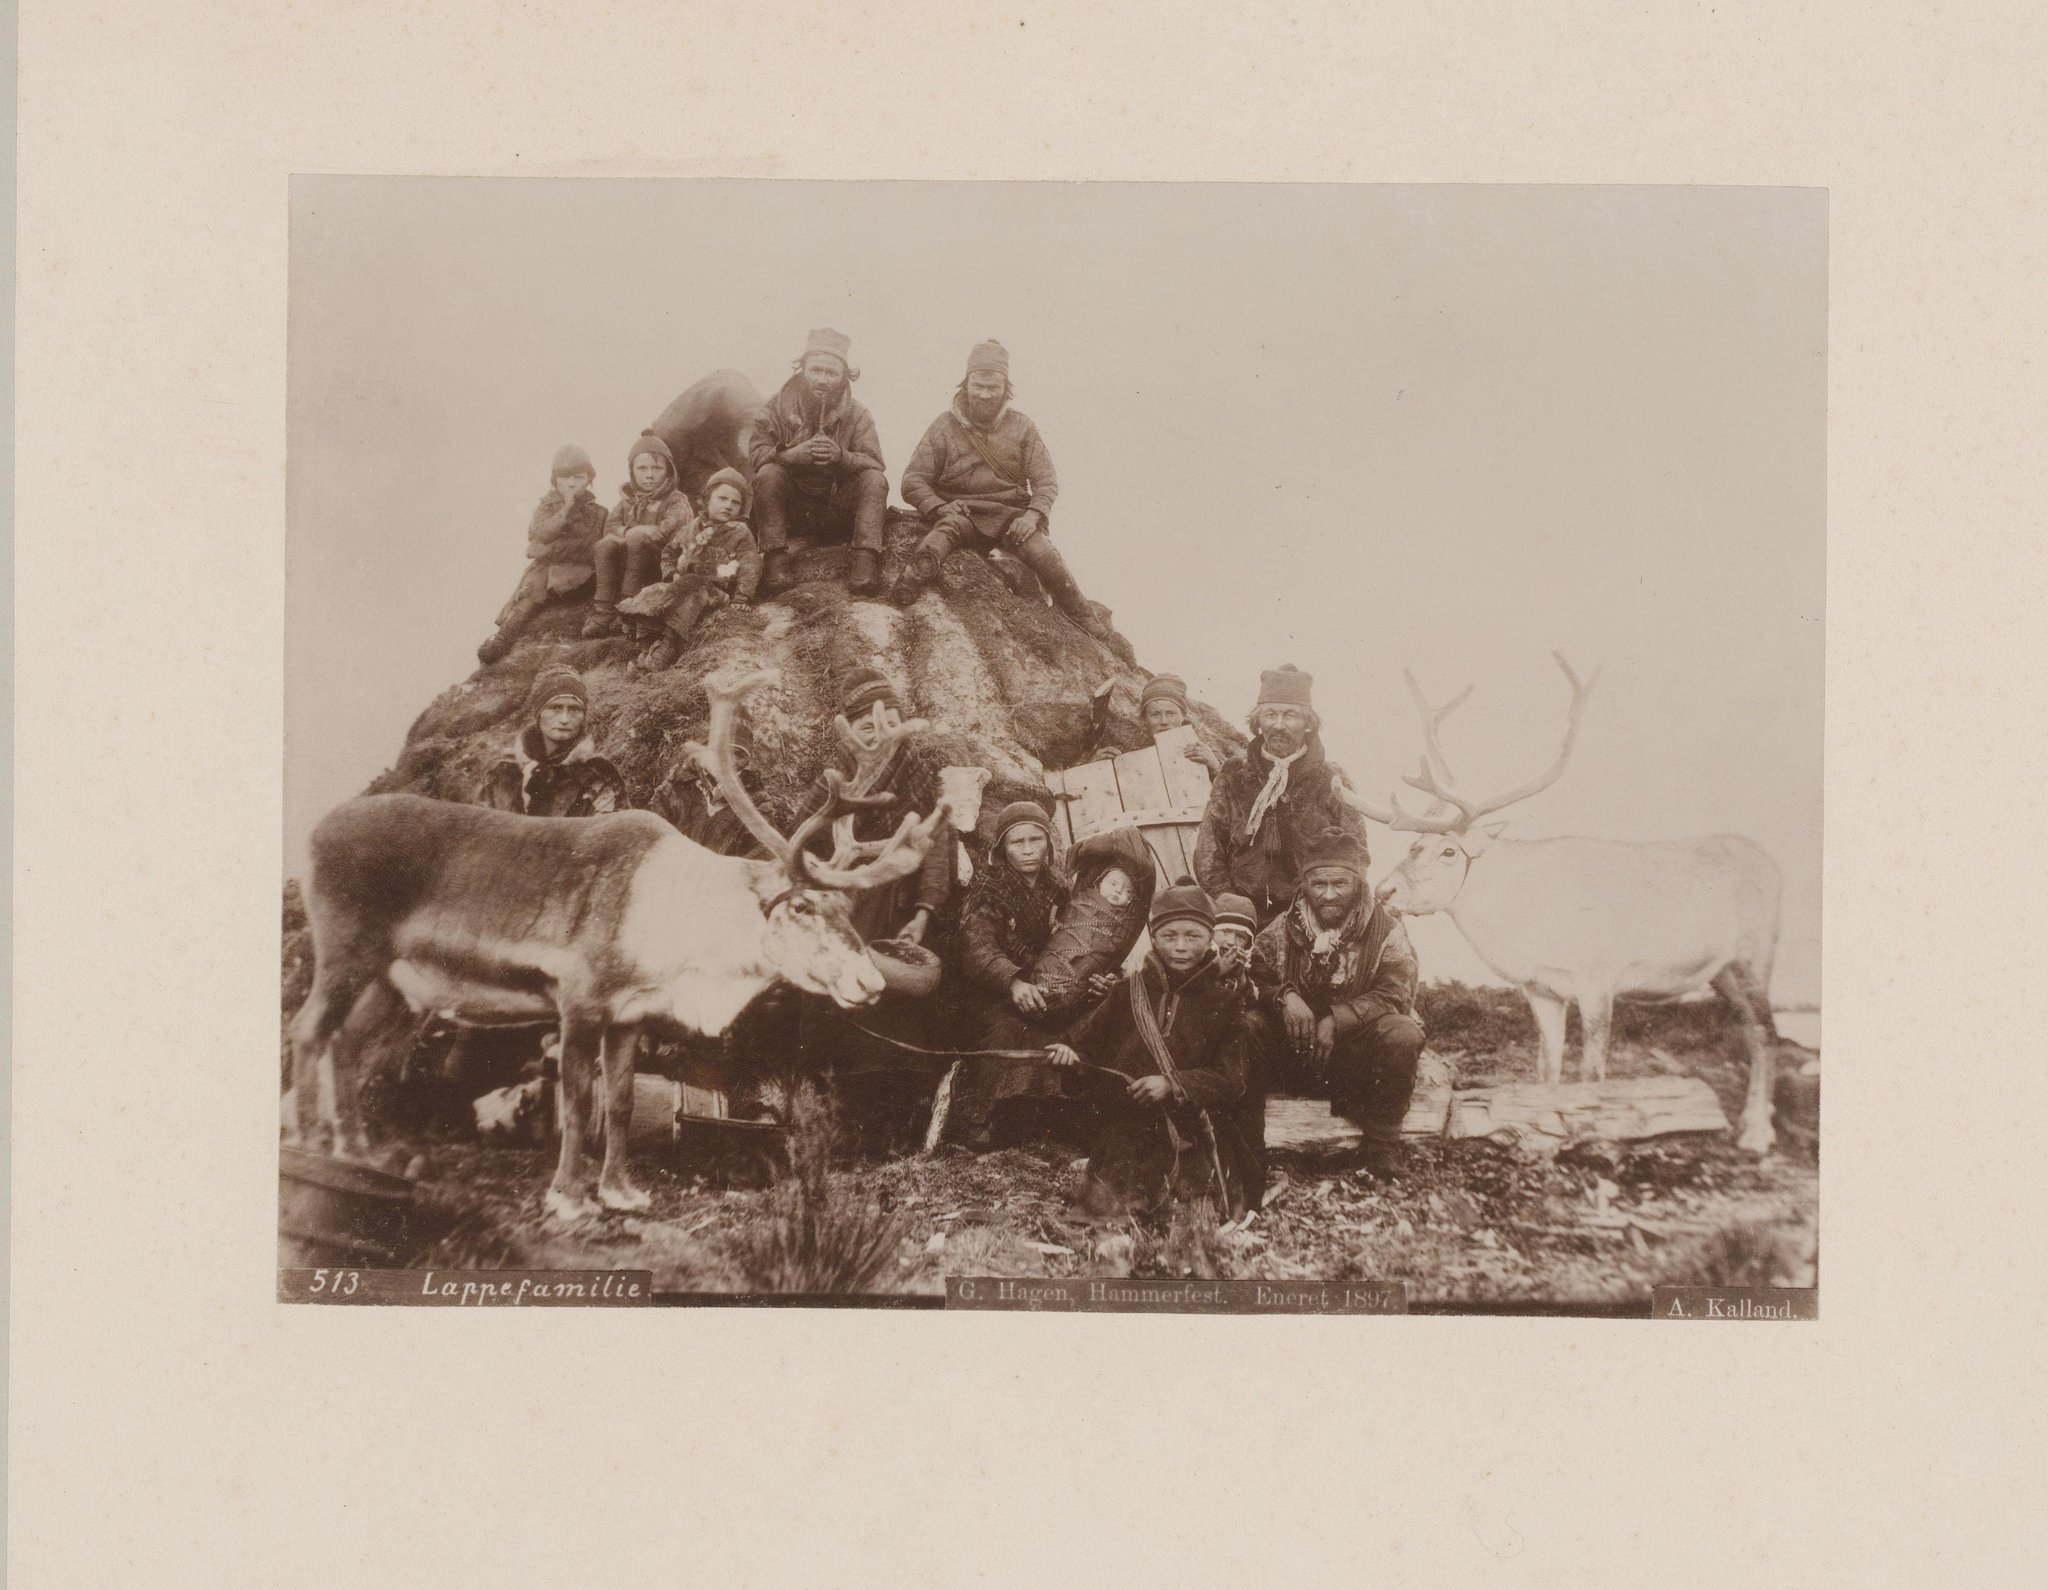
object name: photograph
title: Groepsportret van Samen met rendieren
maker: anthon kalland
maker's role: painter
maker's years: 1856-1933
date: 1897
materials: cardboard, paper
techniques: albumen print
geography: hammerfest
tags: hoofed animals: deer, europeans: sami, anonymous historical persons portrayed in a group, in a group-portrait, sápmi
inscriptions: number: ‘513’, inscription: ‘Eneret’